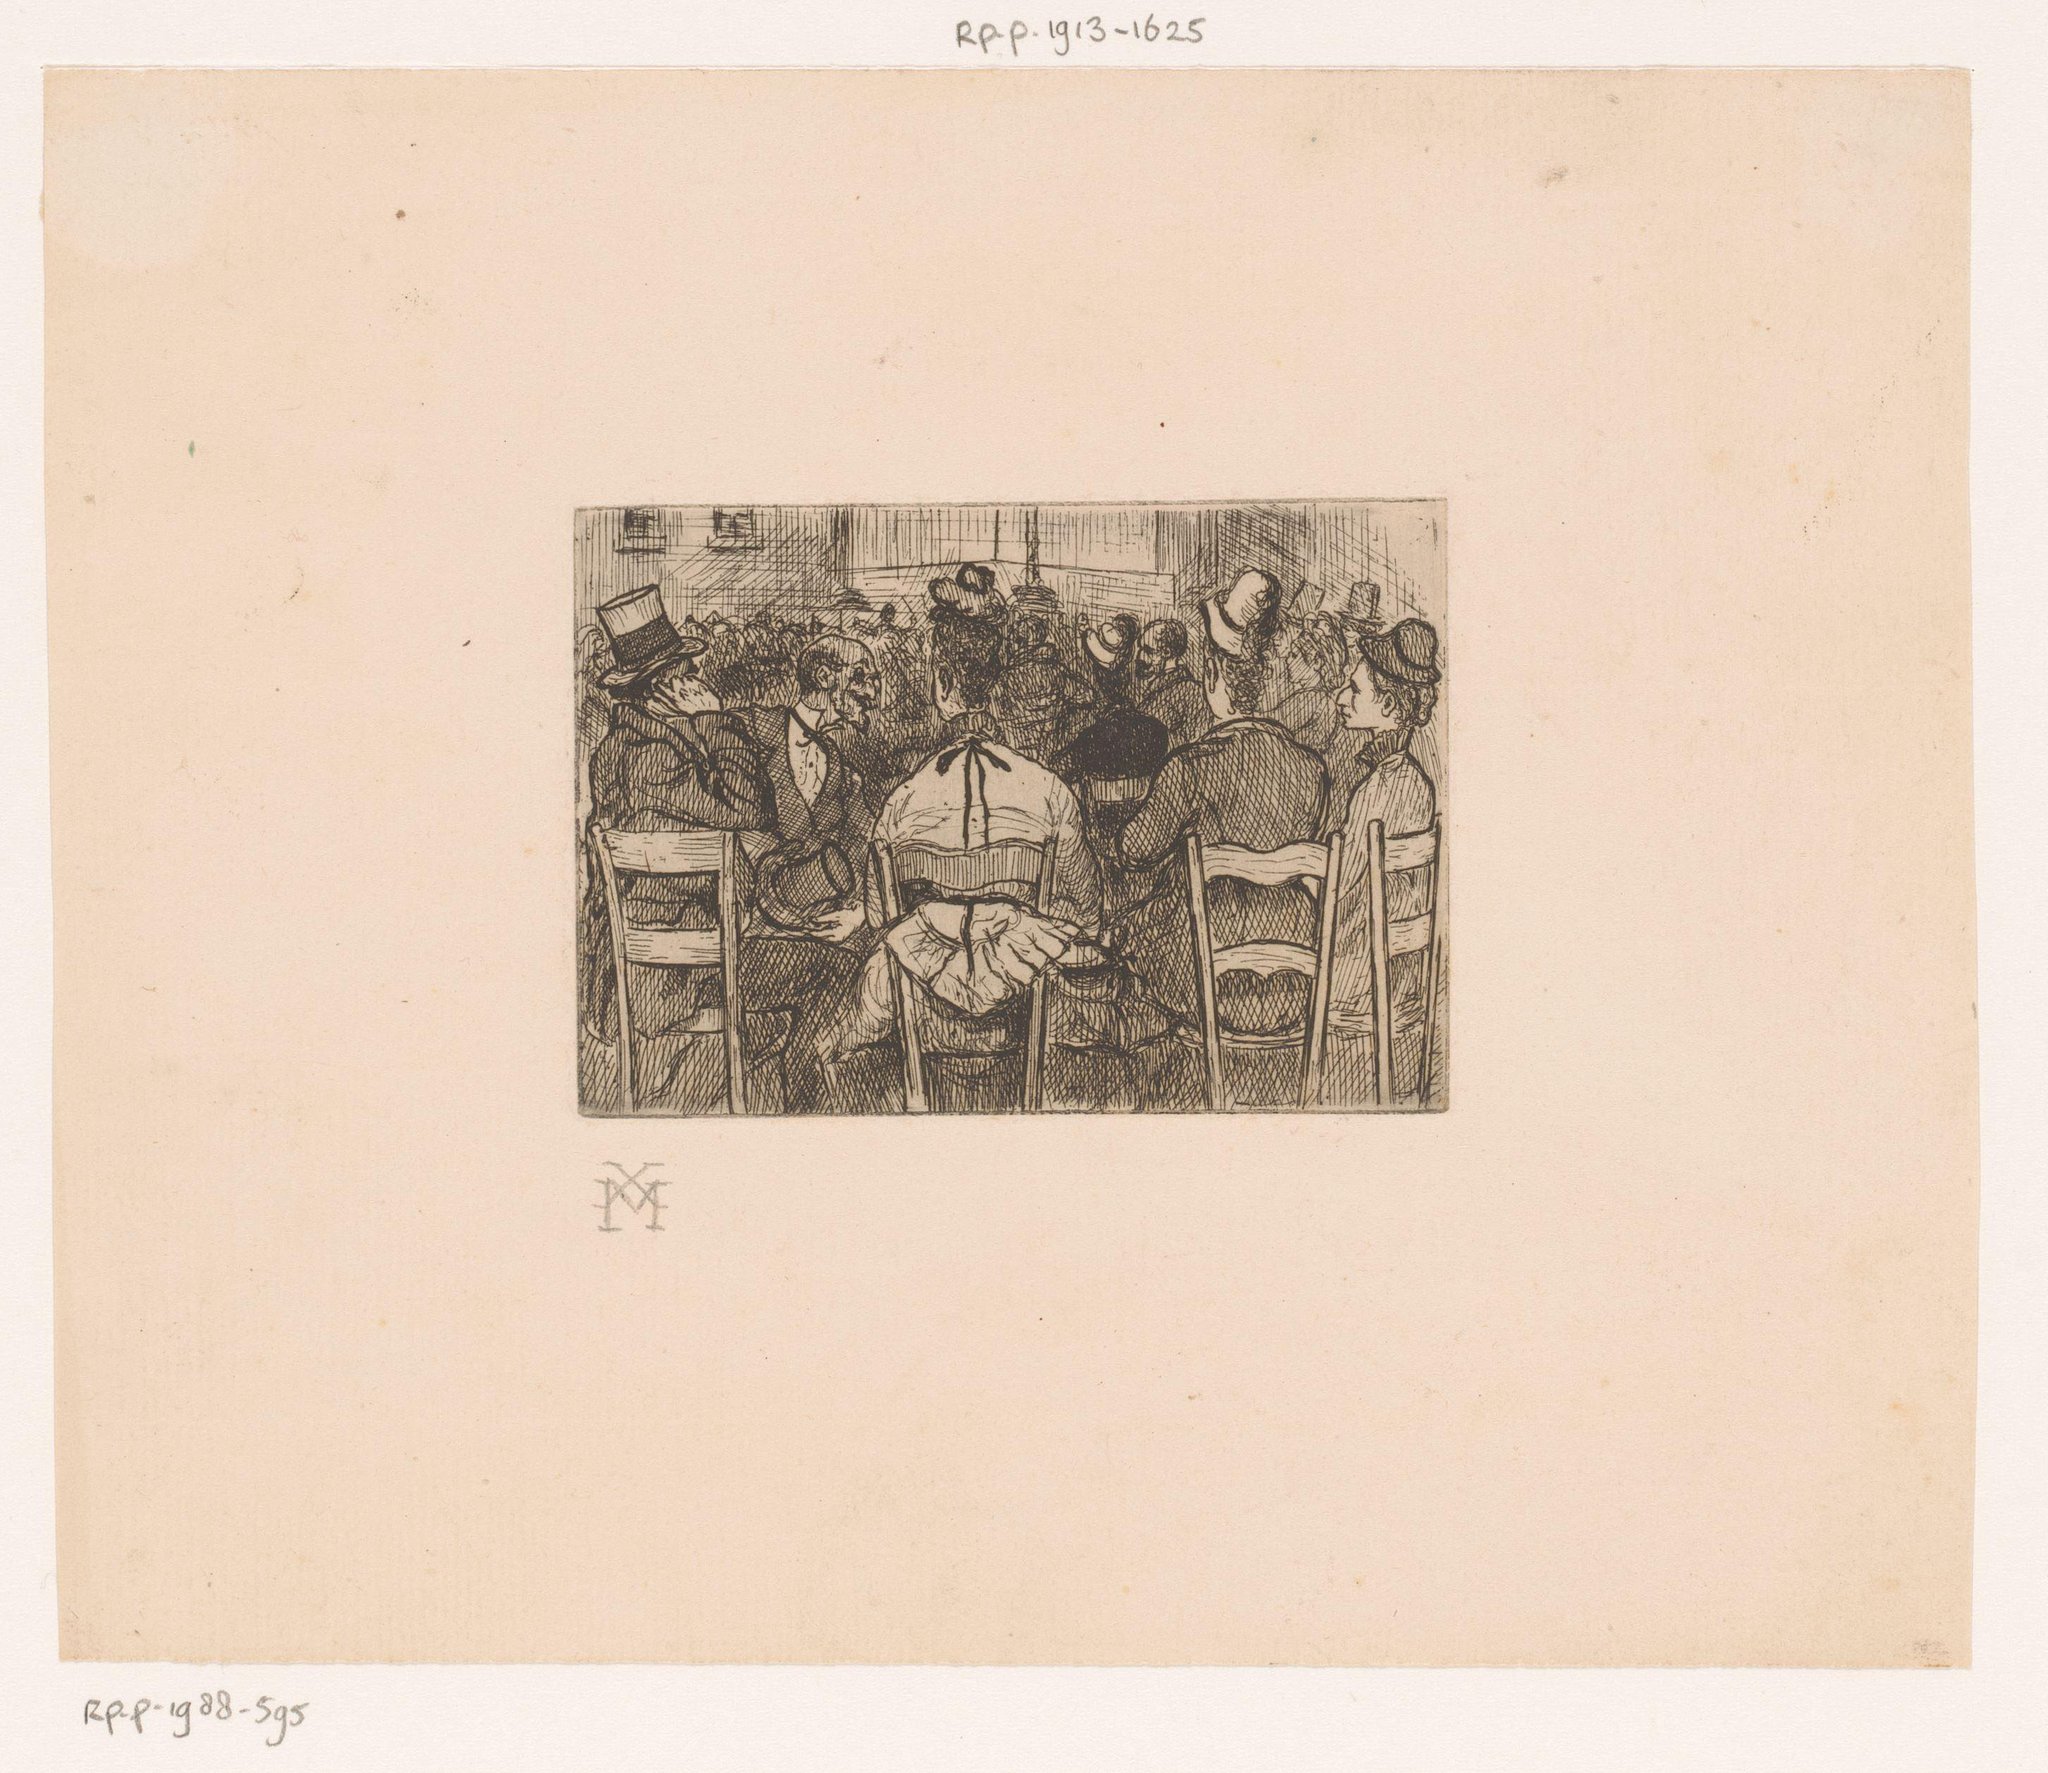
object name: print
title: Publiek bij een concert, op de rug gezien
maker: xavier mellery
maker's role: print maker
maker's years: 1845-1921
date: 1855-1913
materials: paper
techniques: etching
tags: listening to music, the audience ~ art performance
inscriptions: collector's mark: Lugt 2228